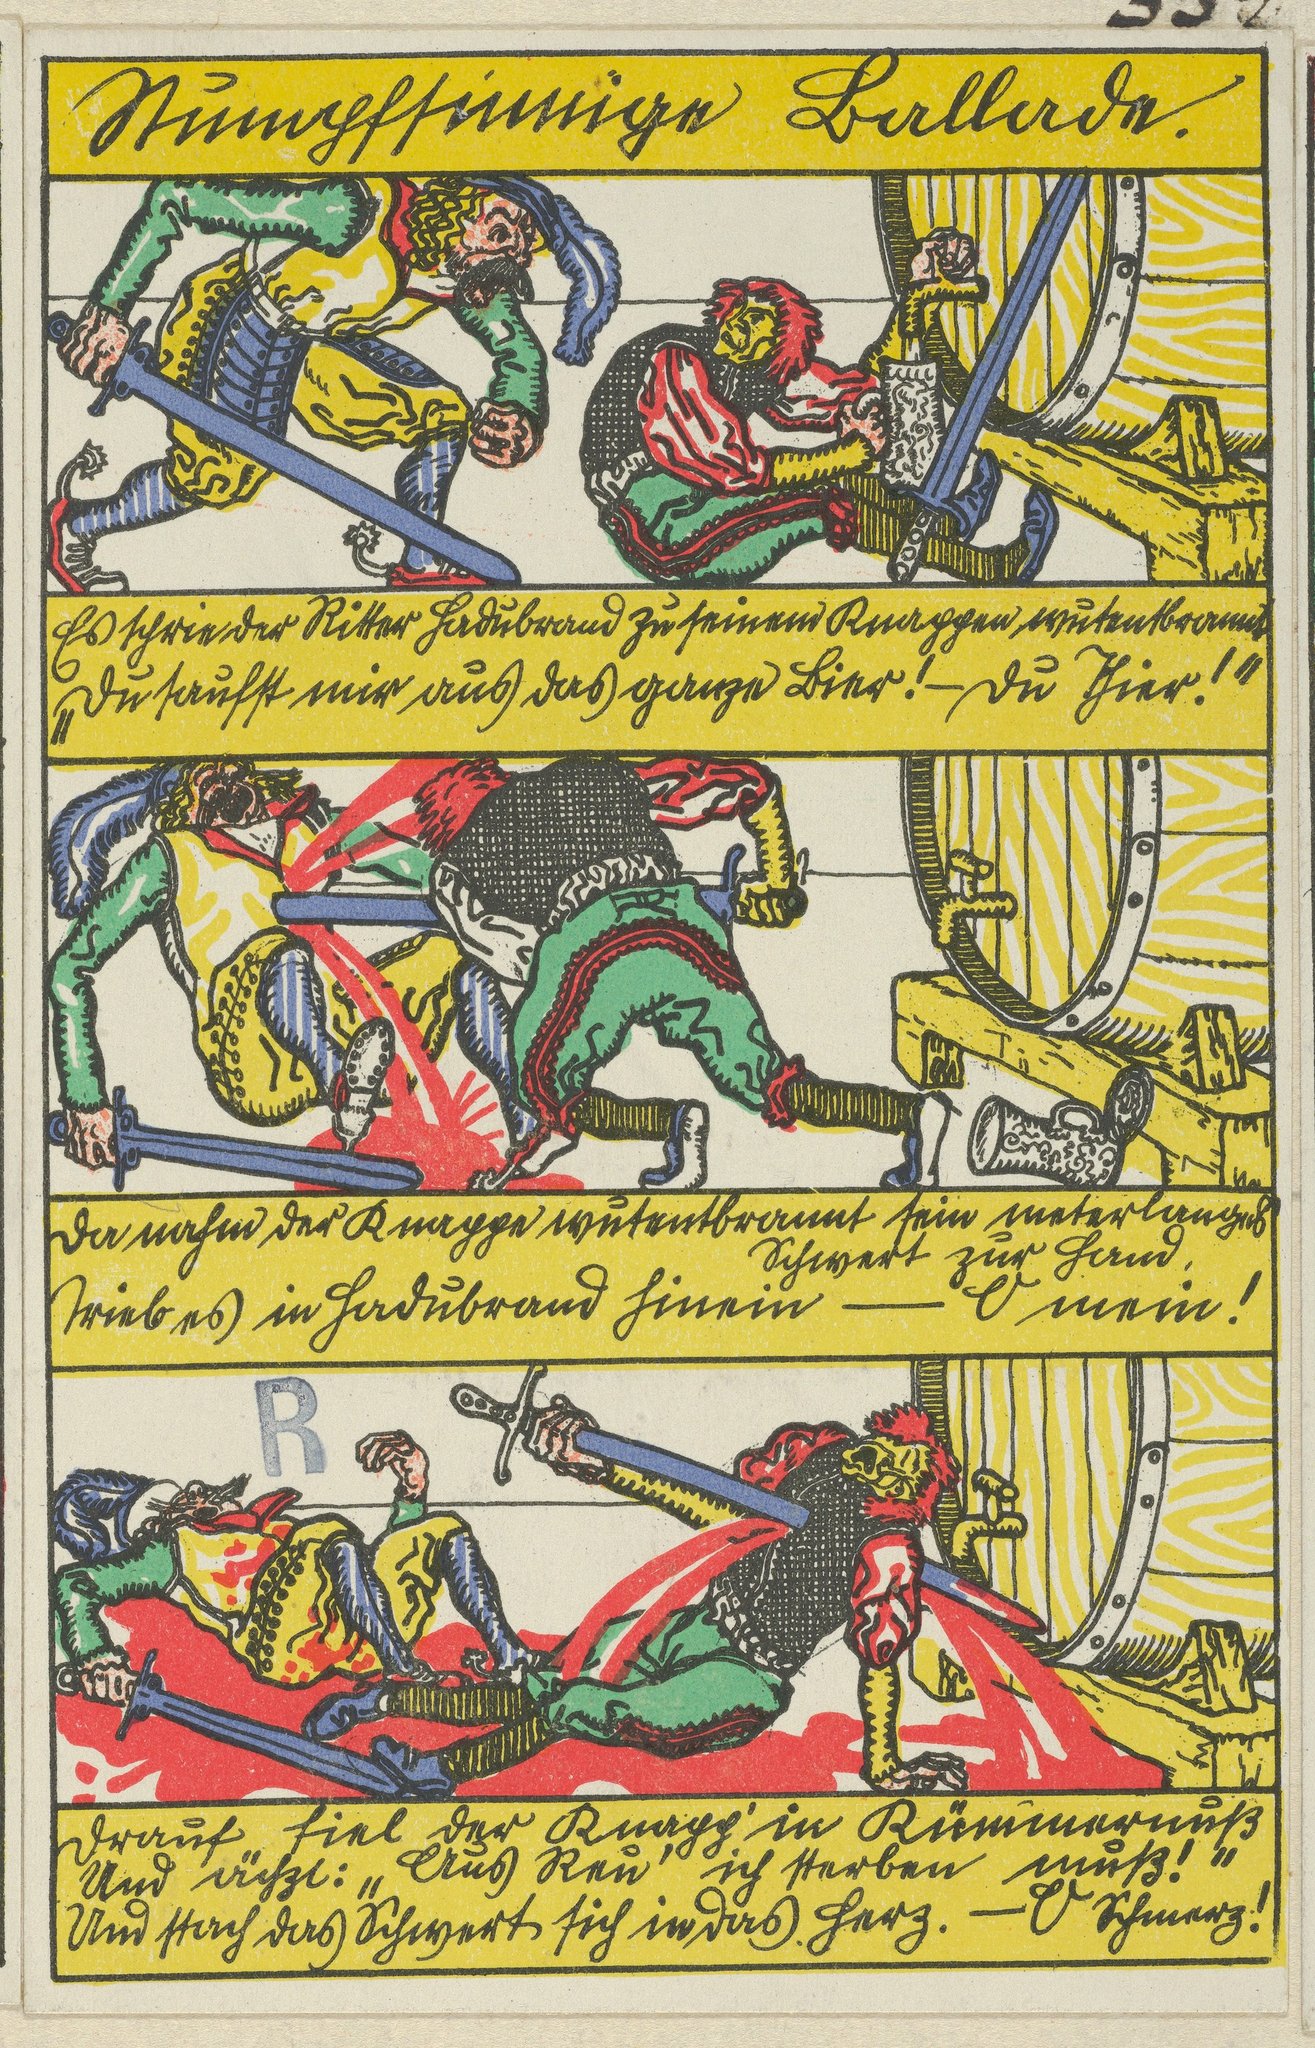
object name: print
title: Mindless Ballad (Stumpfsinnige Ballade)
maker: moriz jung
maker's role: artist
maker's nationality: austrian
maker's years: 1885-1915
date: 1911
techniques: lithograph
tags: swords,men